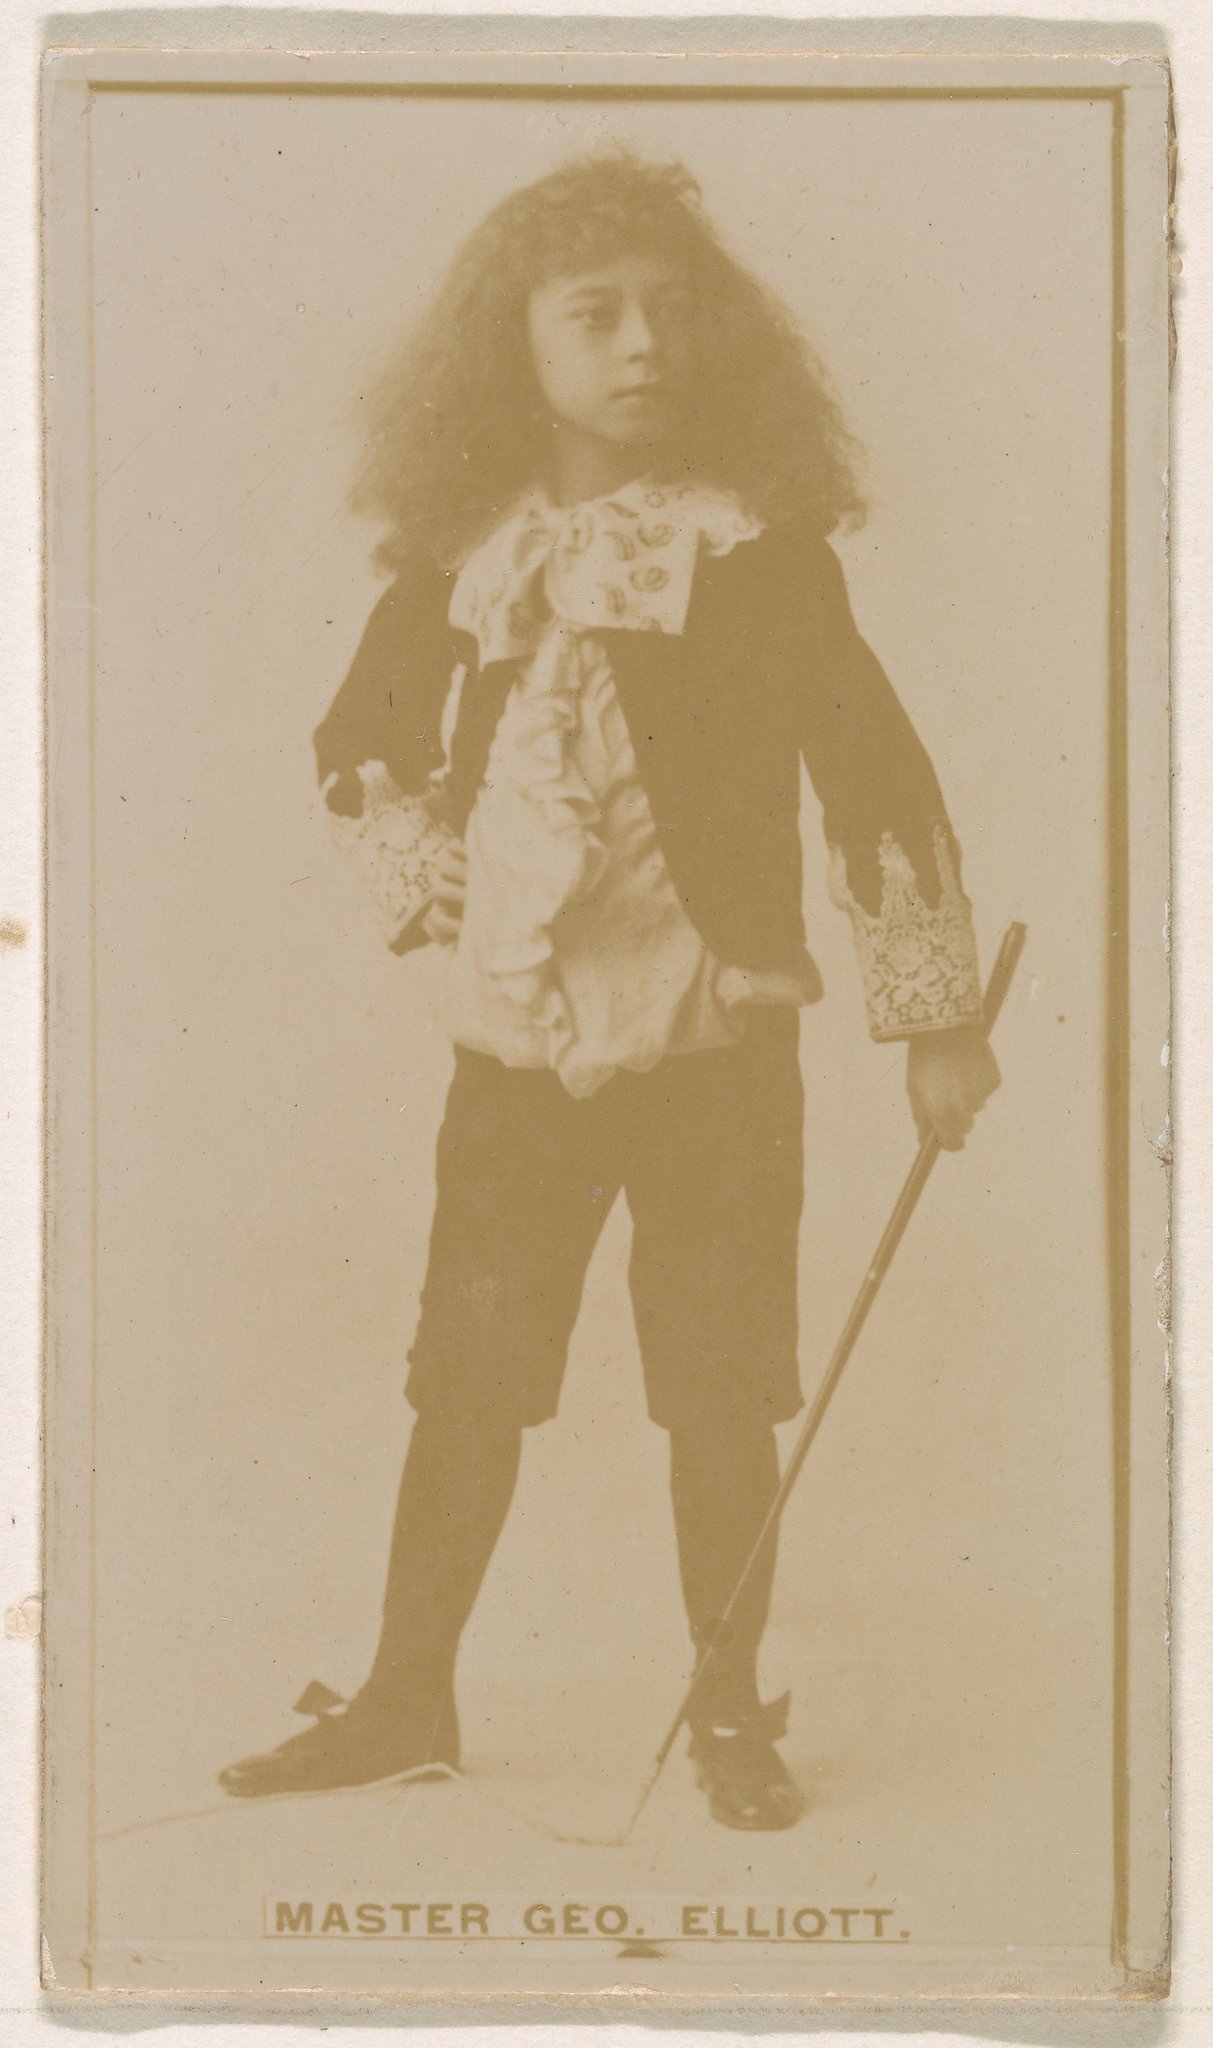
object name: photograph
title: Master George Elliott, from the Actresses series (N245) issued by Kinney Brothers to promote Sweet Caporal Cigarettes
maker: kinney brothers tobacco company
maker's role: publisher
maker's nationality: american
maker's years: 1869-2011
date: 1890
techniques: albumen silver print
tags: boys,portraits,actors